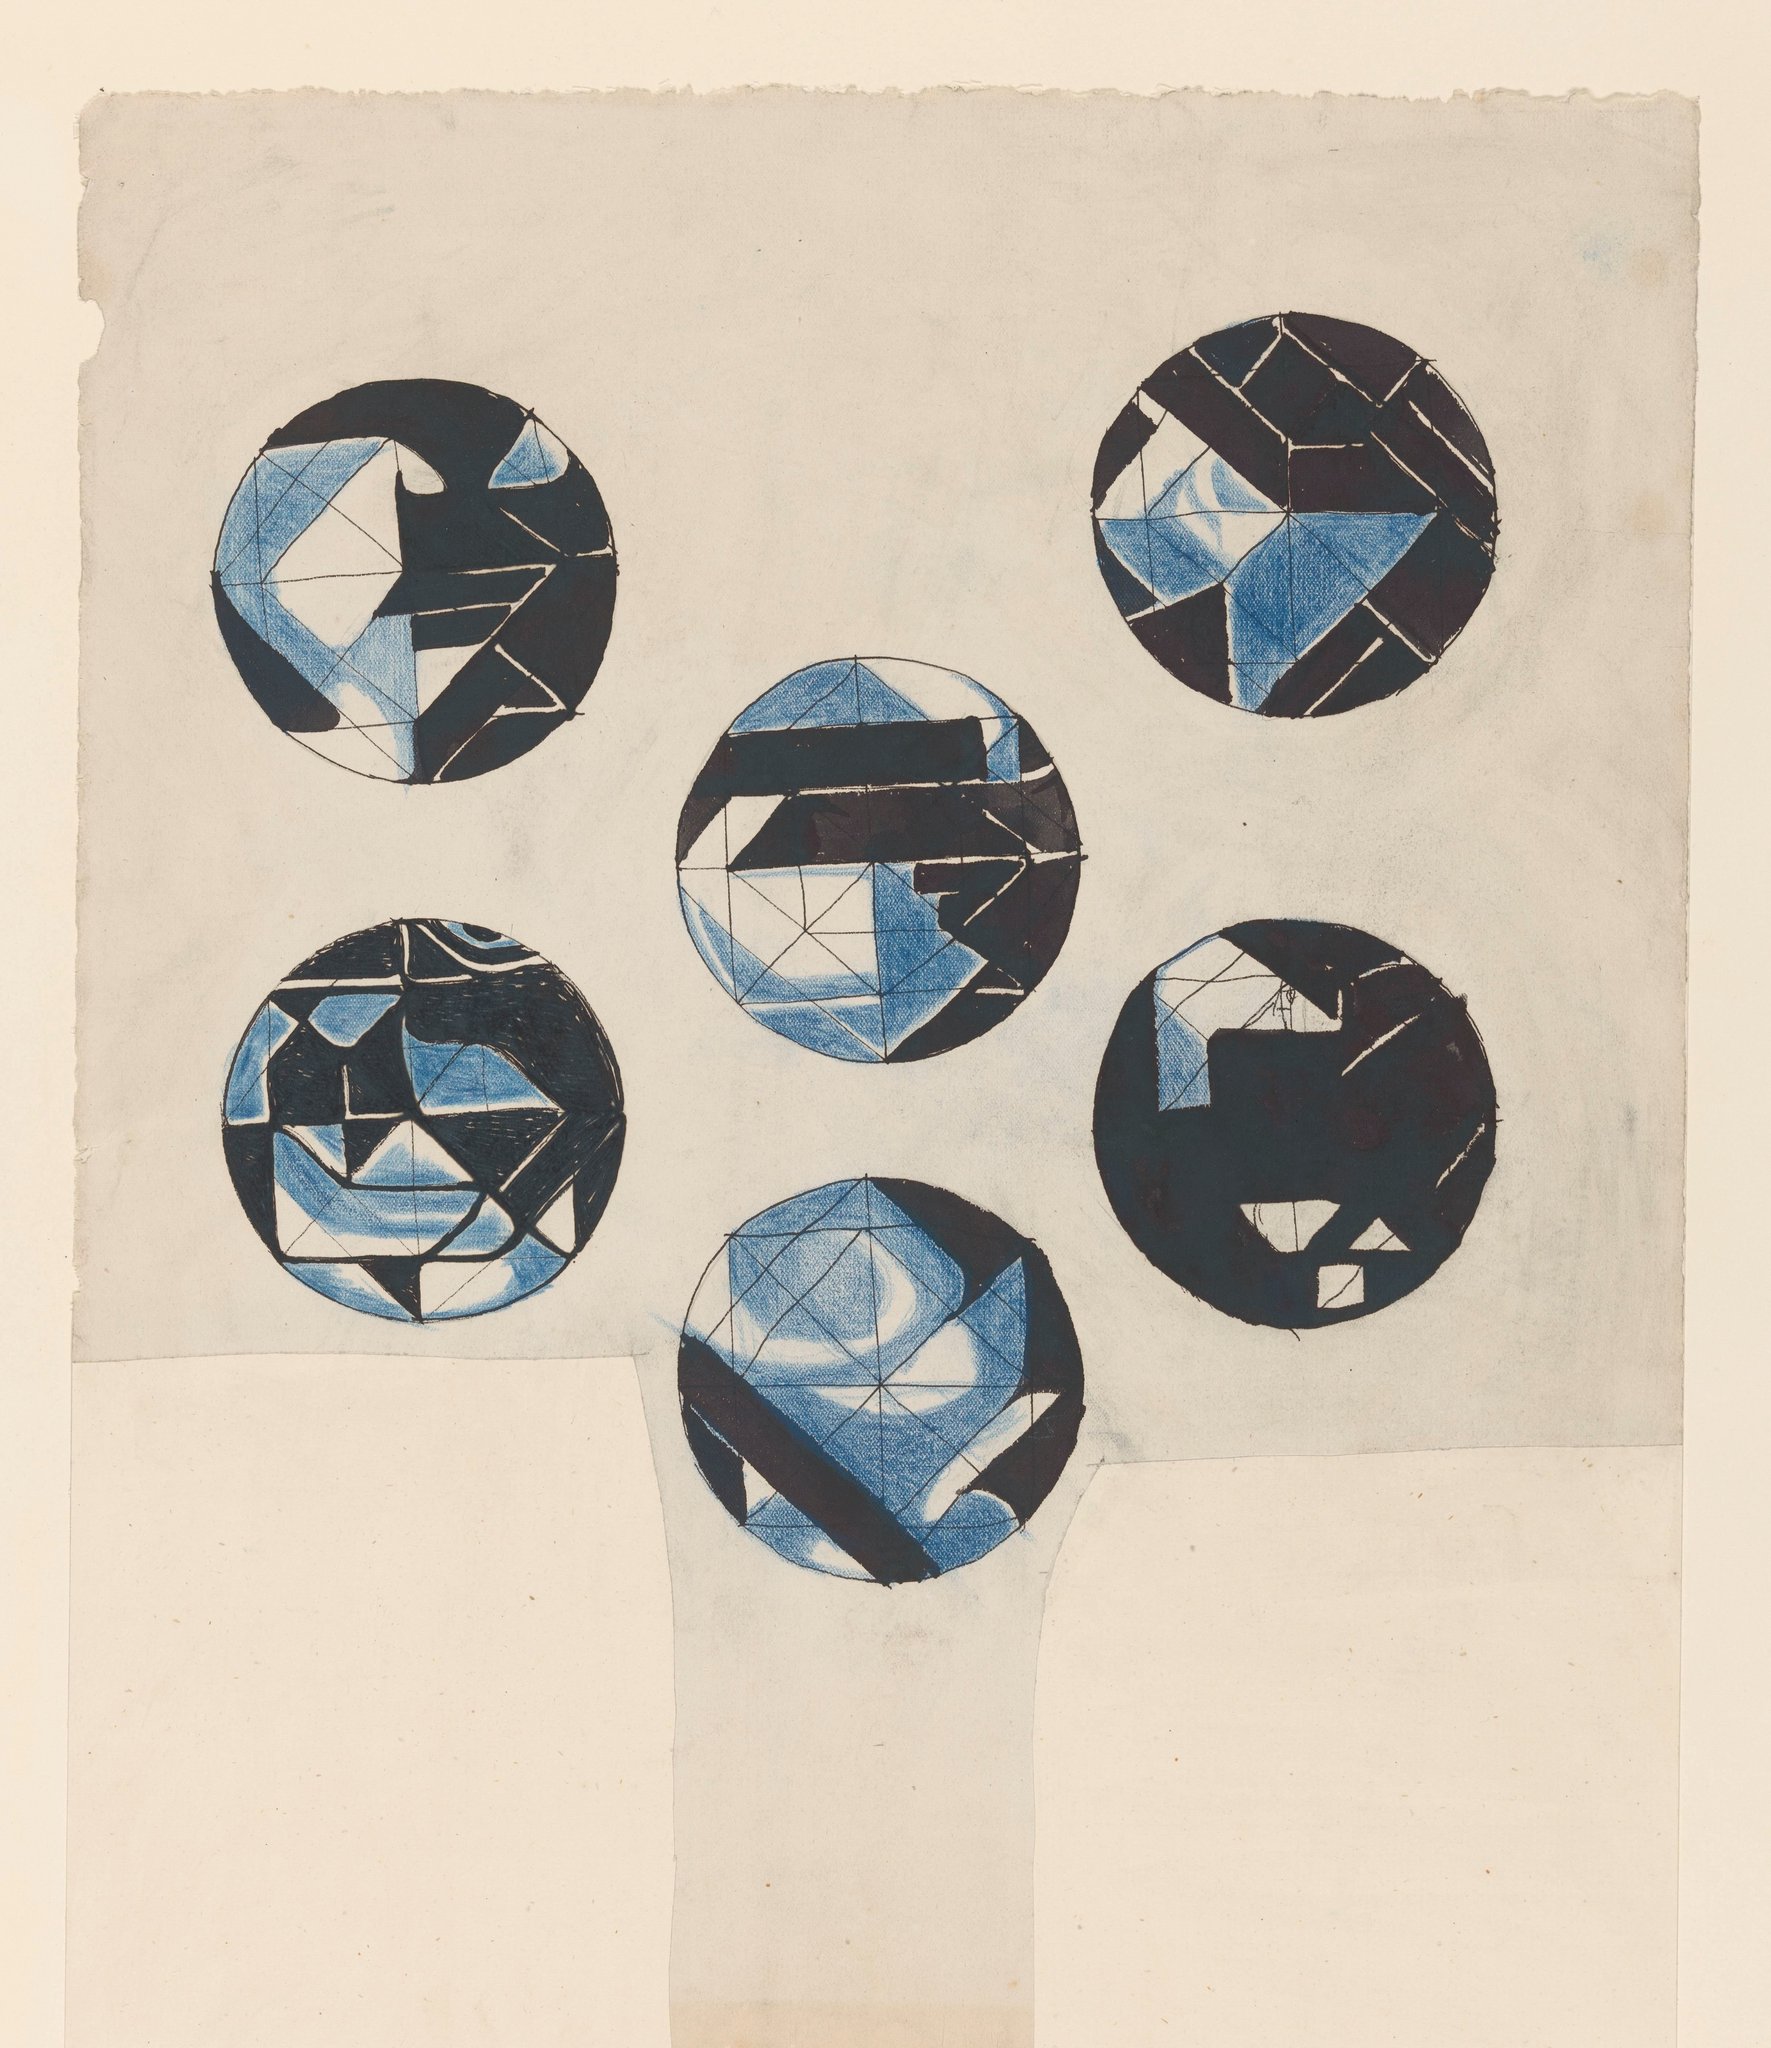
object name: drawing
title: Zes cirkelvormige ontwerpen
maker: richard nicolaüs roland holst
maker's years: 1868-1938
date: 1878-1938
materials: ink, paper, pencil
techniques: pen